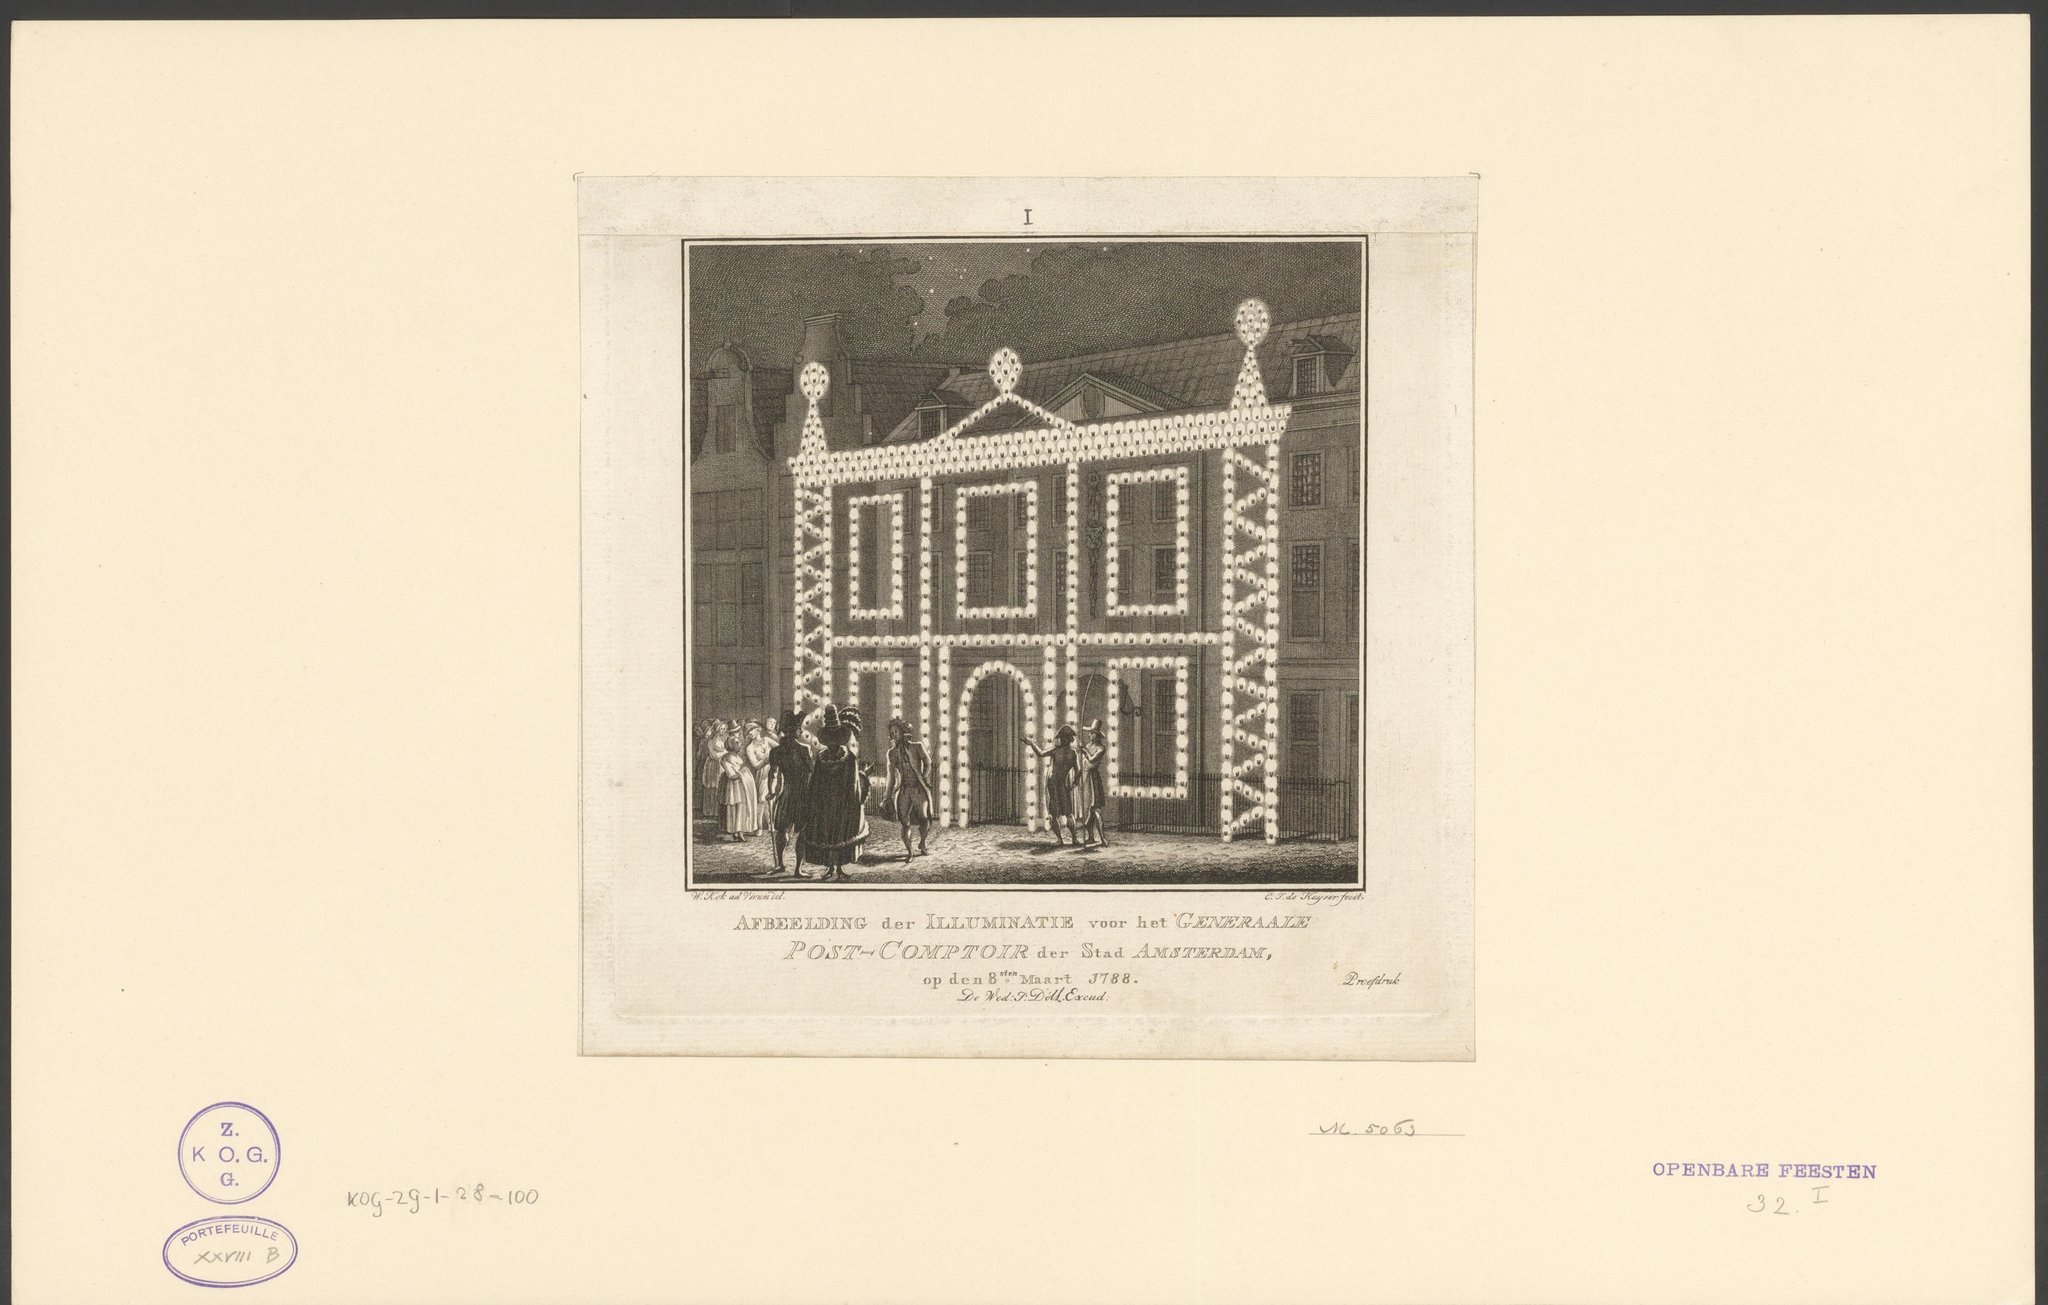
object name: print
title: Verlichting van het postkantoor te Amsterdam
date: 1788-1790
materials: paper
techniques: engraving, etching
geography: amsterdam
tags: post-office, lighting; lamps, amsterdam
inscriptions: stamp, stamp, collector's mark: Lugt 1641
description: De verlichtte voorgevel van het algemene postkantoor te Amsterdam ter gelegenheid van de 40-ste verjaardag van Willem V. Daarvoor enkele figuren. Onderdeel van een reeks van twaalf platen van de illuminaties en decoraties te Amsterdam op de 40ste verjaardag van prins Willem V op 8 maart 1788. Onderwerpsrubrieken binnen de Atlas Zeden en Gewoonten: Zeden en Gewoonten in Engeren Zin. Volksleven. Openbare feesten. Vorstelijke intochten, (Illuminaties, vuurwerken en dergelijke, openbare feesten).